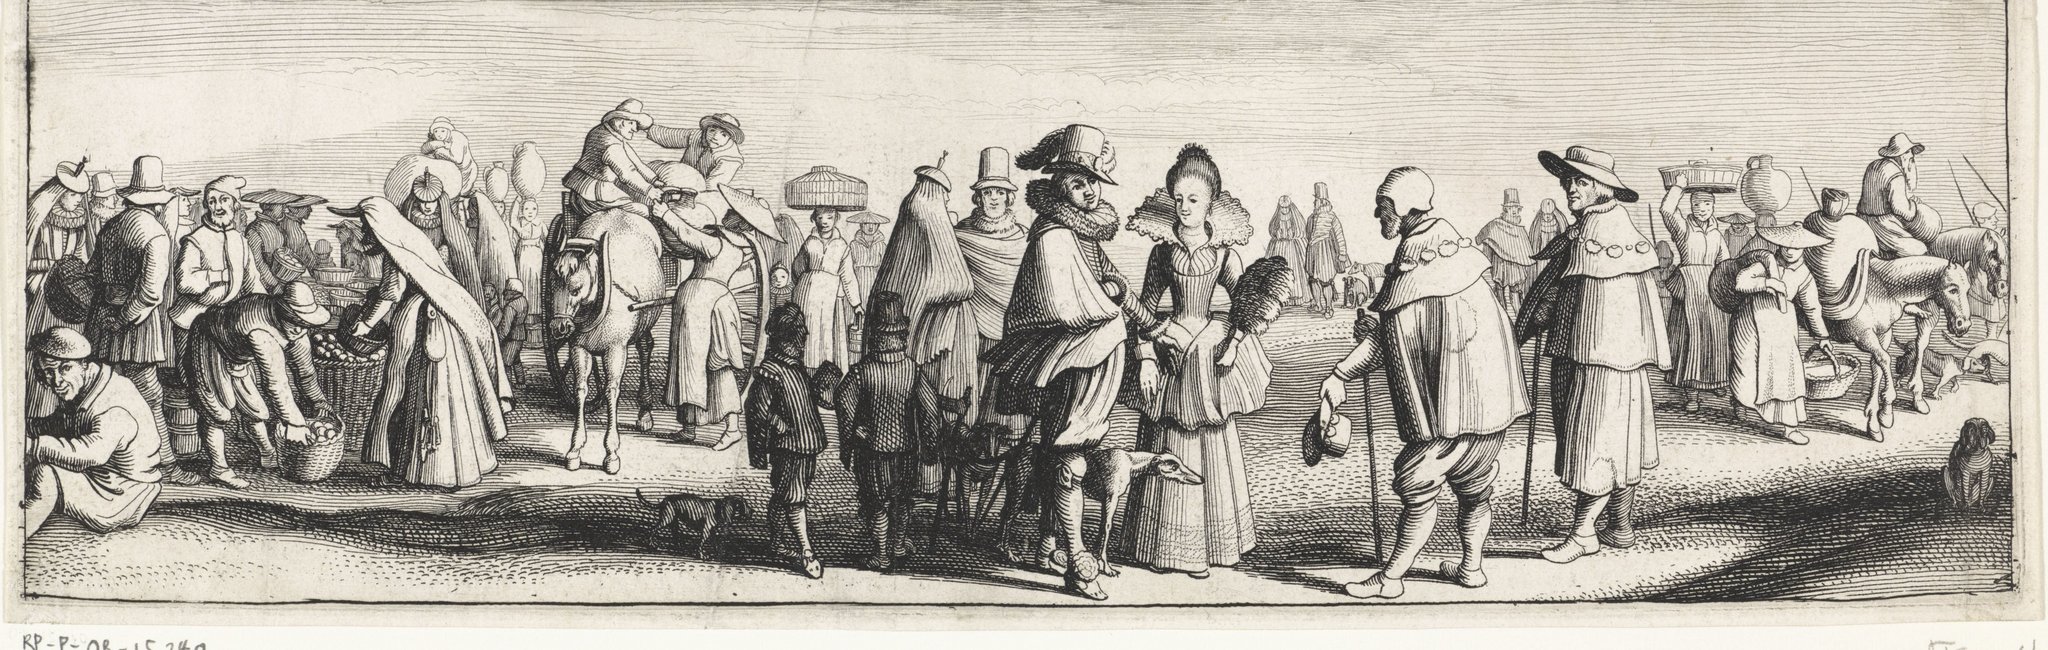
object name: print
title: Markt, serie B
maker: jan van de velde (ii)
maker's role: draughtsman, painter, print maker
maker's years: 1593-1641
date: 1603-1633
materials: paper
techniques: engraving, etching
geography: northern netherlands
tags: pilgrim(s), neck-gear ~ clothing (with name), cape (huik) (+ women's clothes), market, neck-gear: collar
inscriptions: collector's mark: Lugt 240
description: Een groepje elegant geklede burgers, voor wie twee pelgrims, op een markt. Een van hen vraagt een aalmoes. Links een vrouw met huik, bij een mand met fruit. Daarnaast wordt een kar uitgeladen. Derde prent van een fries bestaande uit vier prenten, voorstellende een markt.